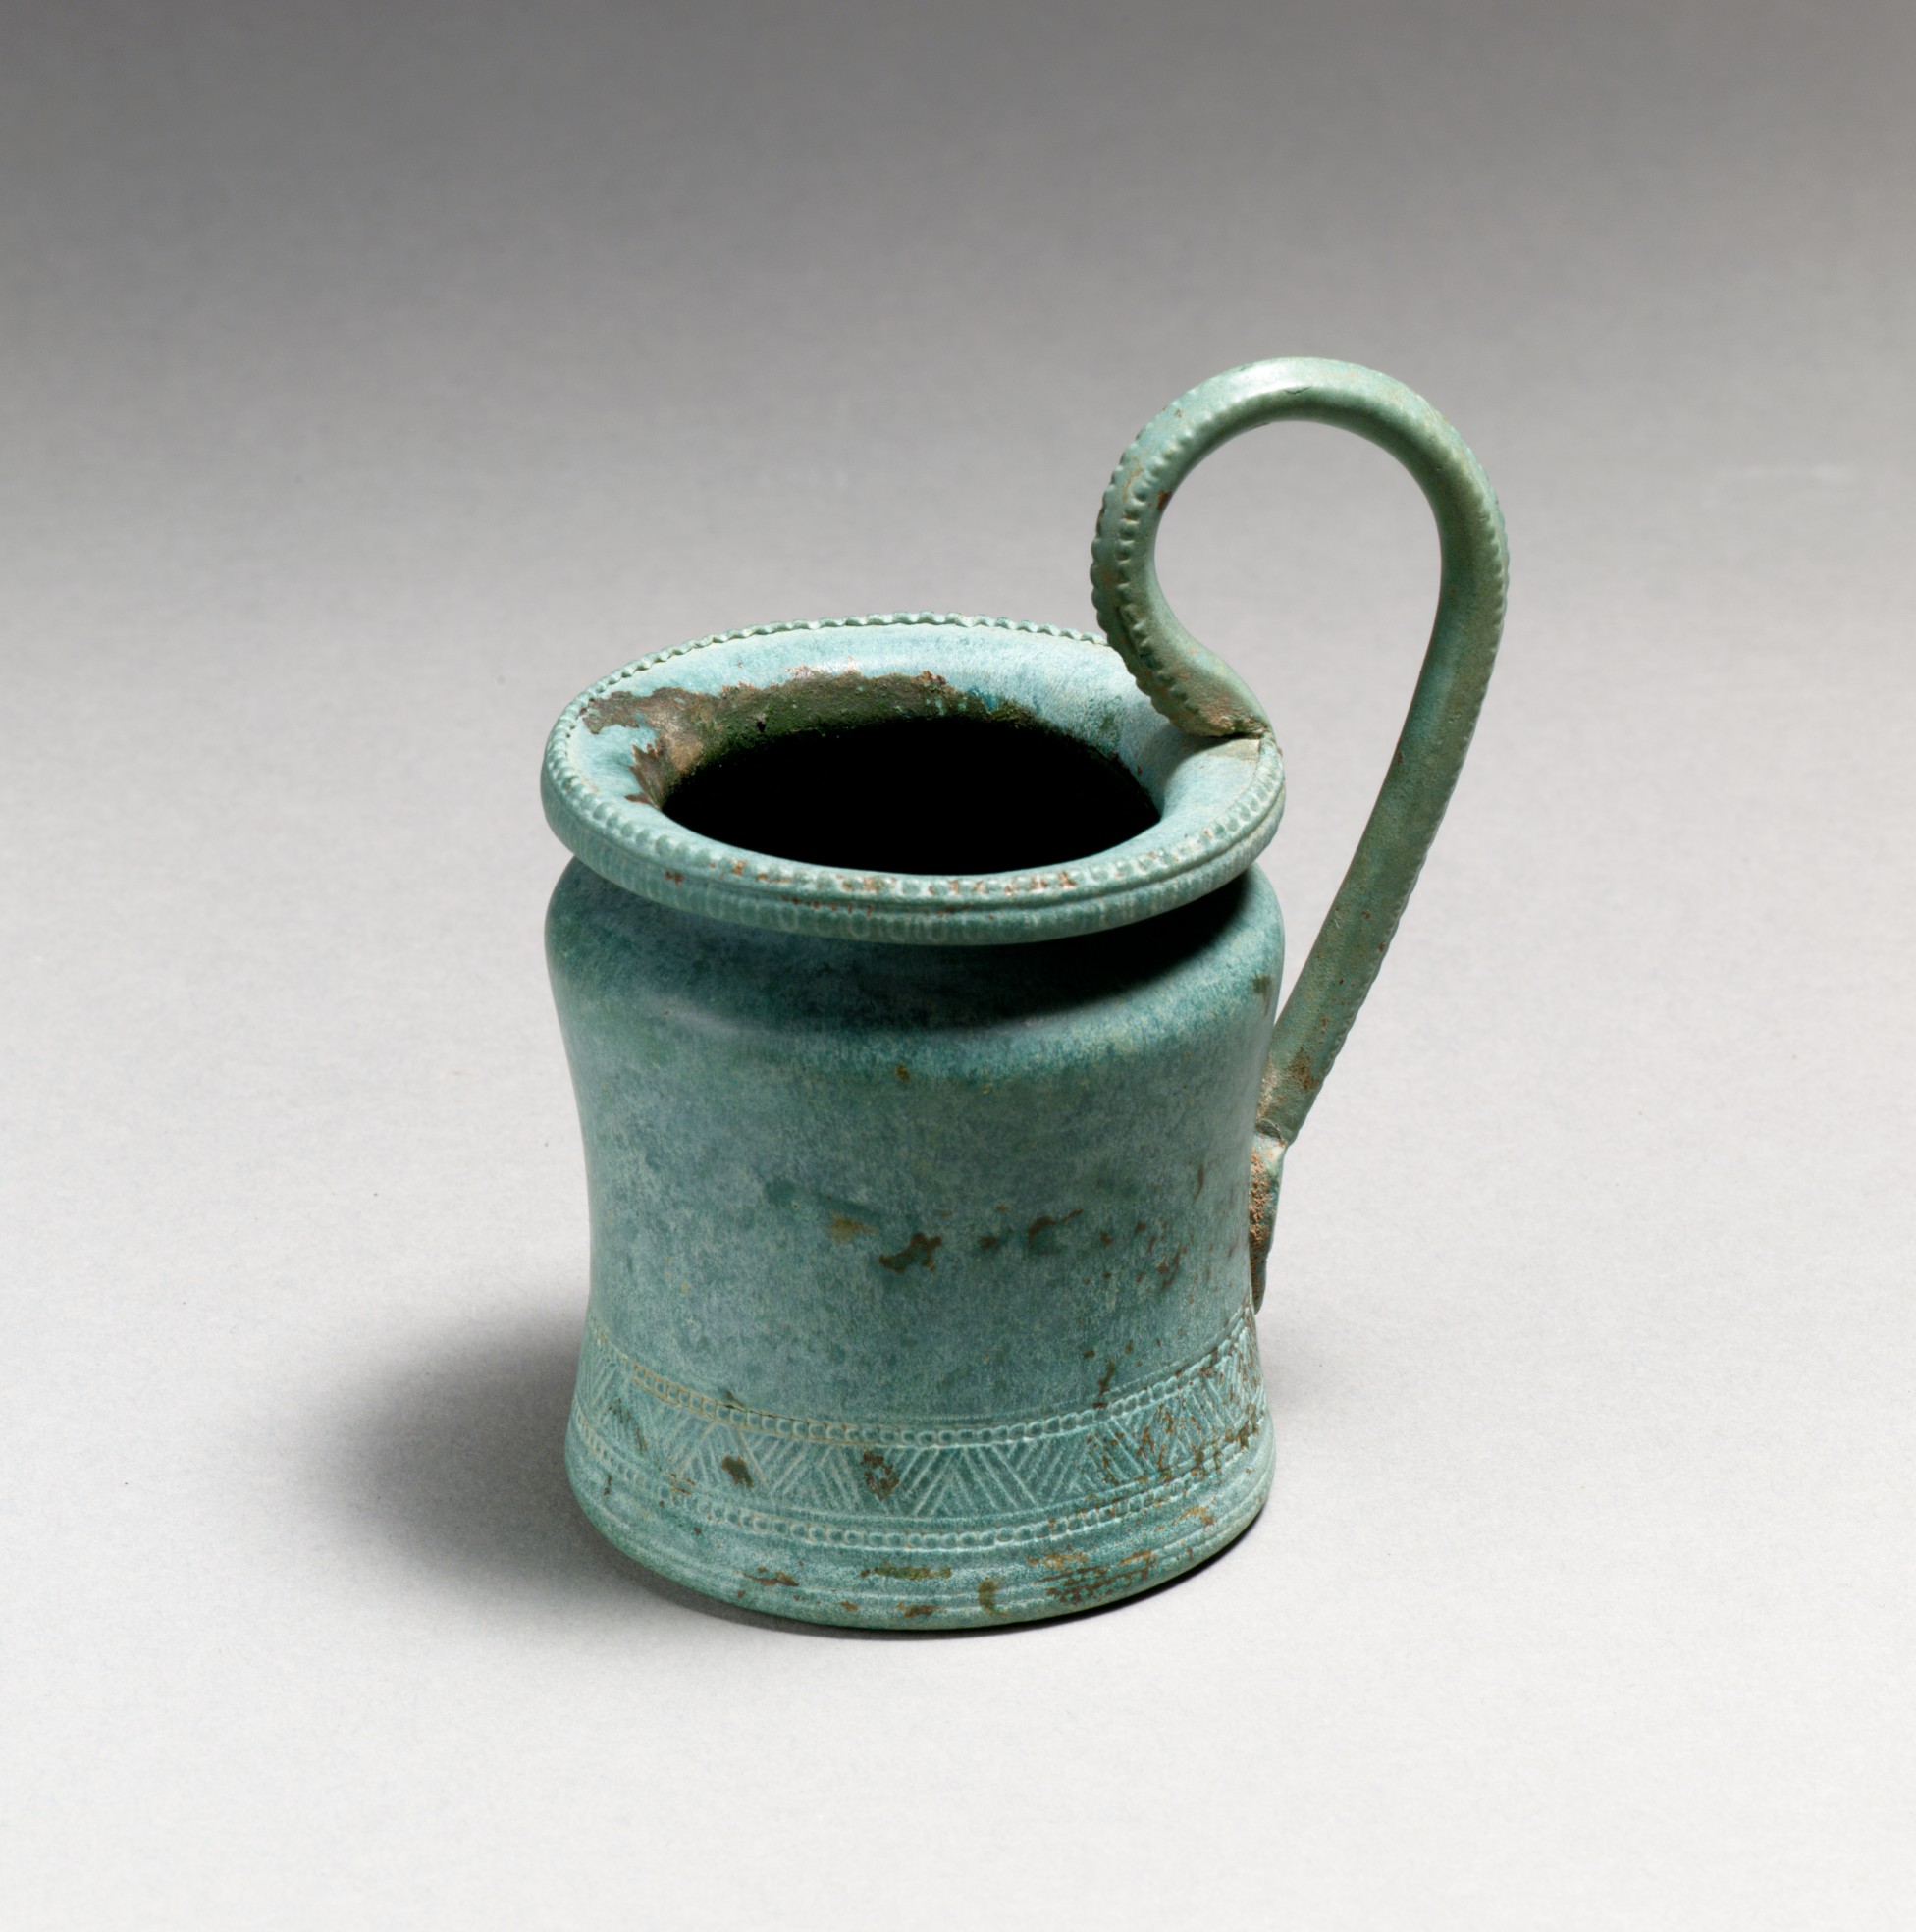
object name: cup with handle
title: Bronze kyathos (ladle)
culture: etruscan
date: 450-400 BCE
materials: bronze